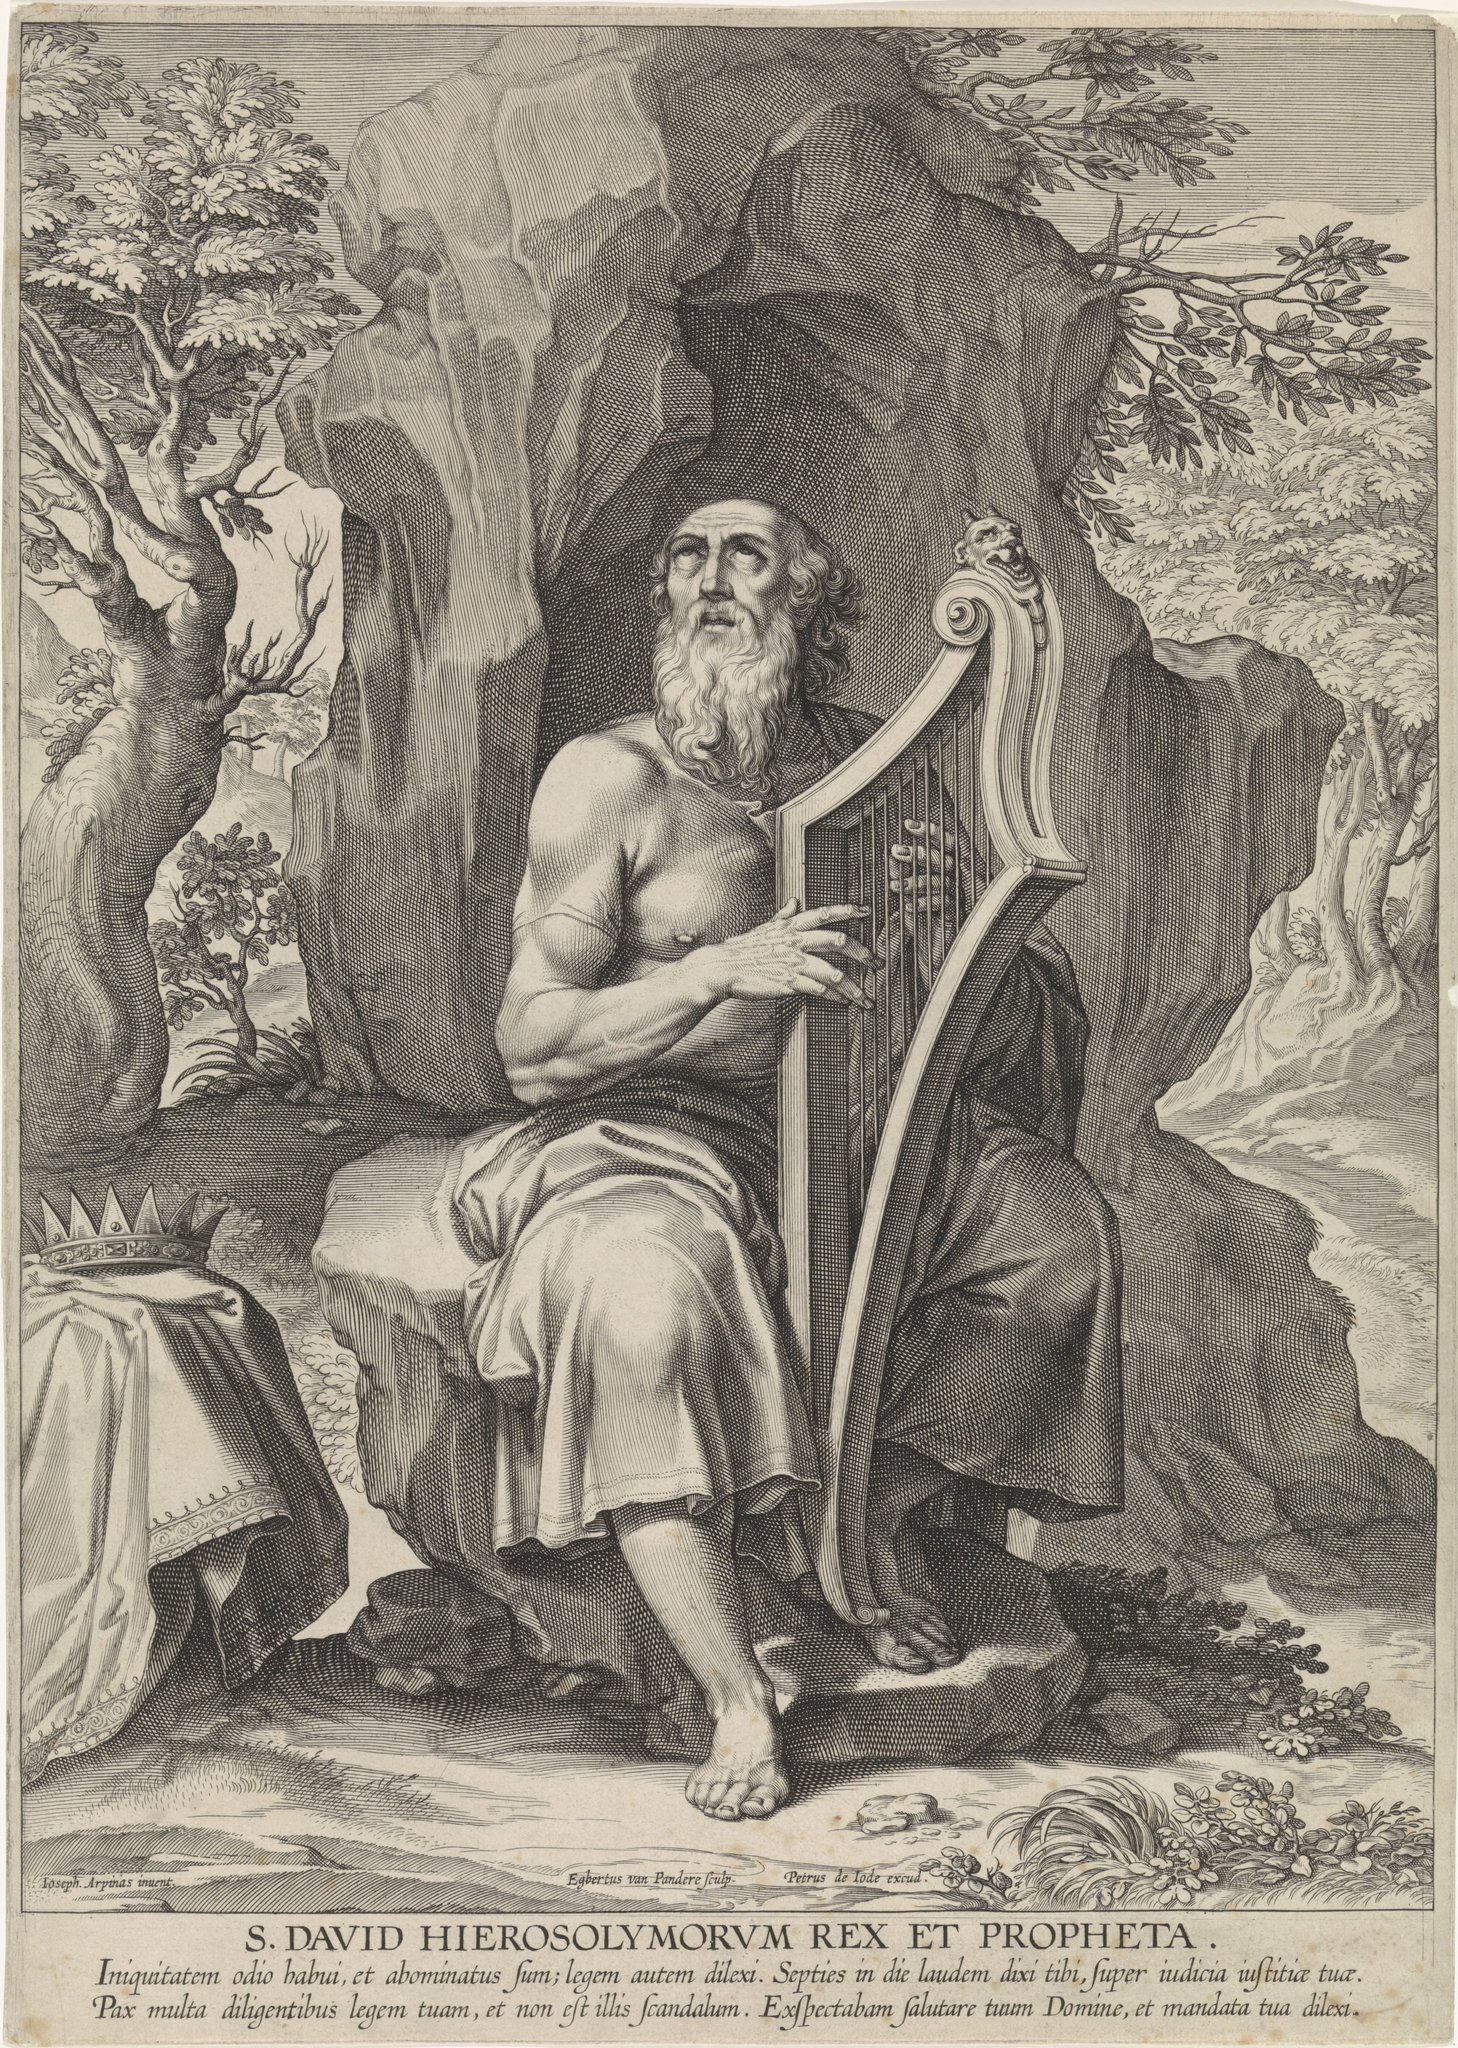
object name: print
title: David speelt op zijn harp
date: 1590-1637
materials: paper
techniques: engraving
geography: antwerp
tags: david as musician, usually playing the harp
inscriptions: collector's mark: Lugt 240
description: Bosrijk landschap met David die op zijn harp speelt. Hij zit op een steen bij een rots en heeft zijn ogen ten hemel geslagen. Naast hem op een steen ligt zijn kroon. In de marge een drieregelig onderschrift in het Latijn.